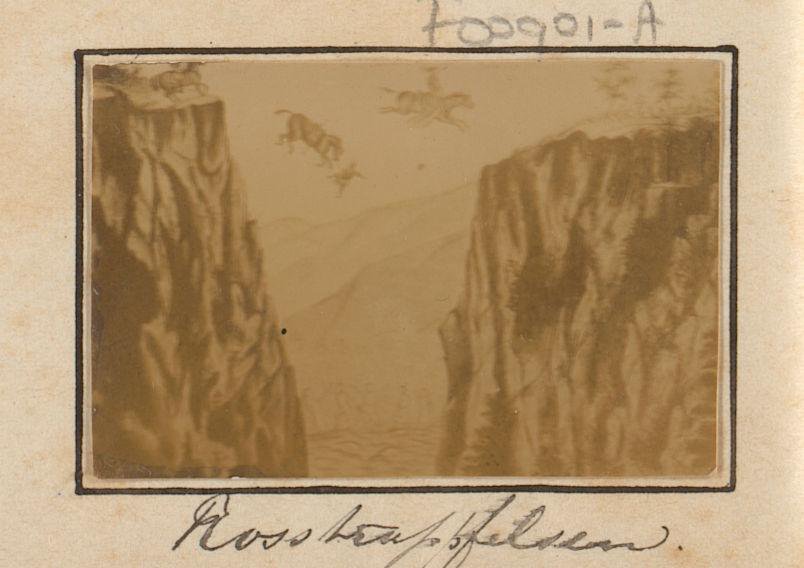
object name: photograph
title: Fotoreproductie van een prent van paarden die over een kloof springen waarbij een paard en ruiter in het ravijn vallen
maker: Anonymous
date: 1885-1891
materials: photographic support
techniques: albumen print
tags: ravine, chasm, abyss, canyon, horse, germany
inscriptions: annotation: ‘[...] klaar die vinden/ 't prachtig maar [...]/ (...)’, annotation: ‘Rosstrappfelsen’